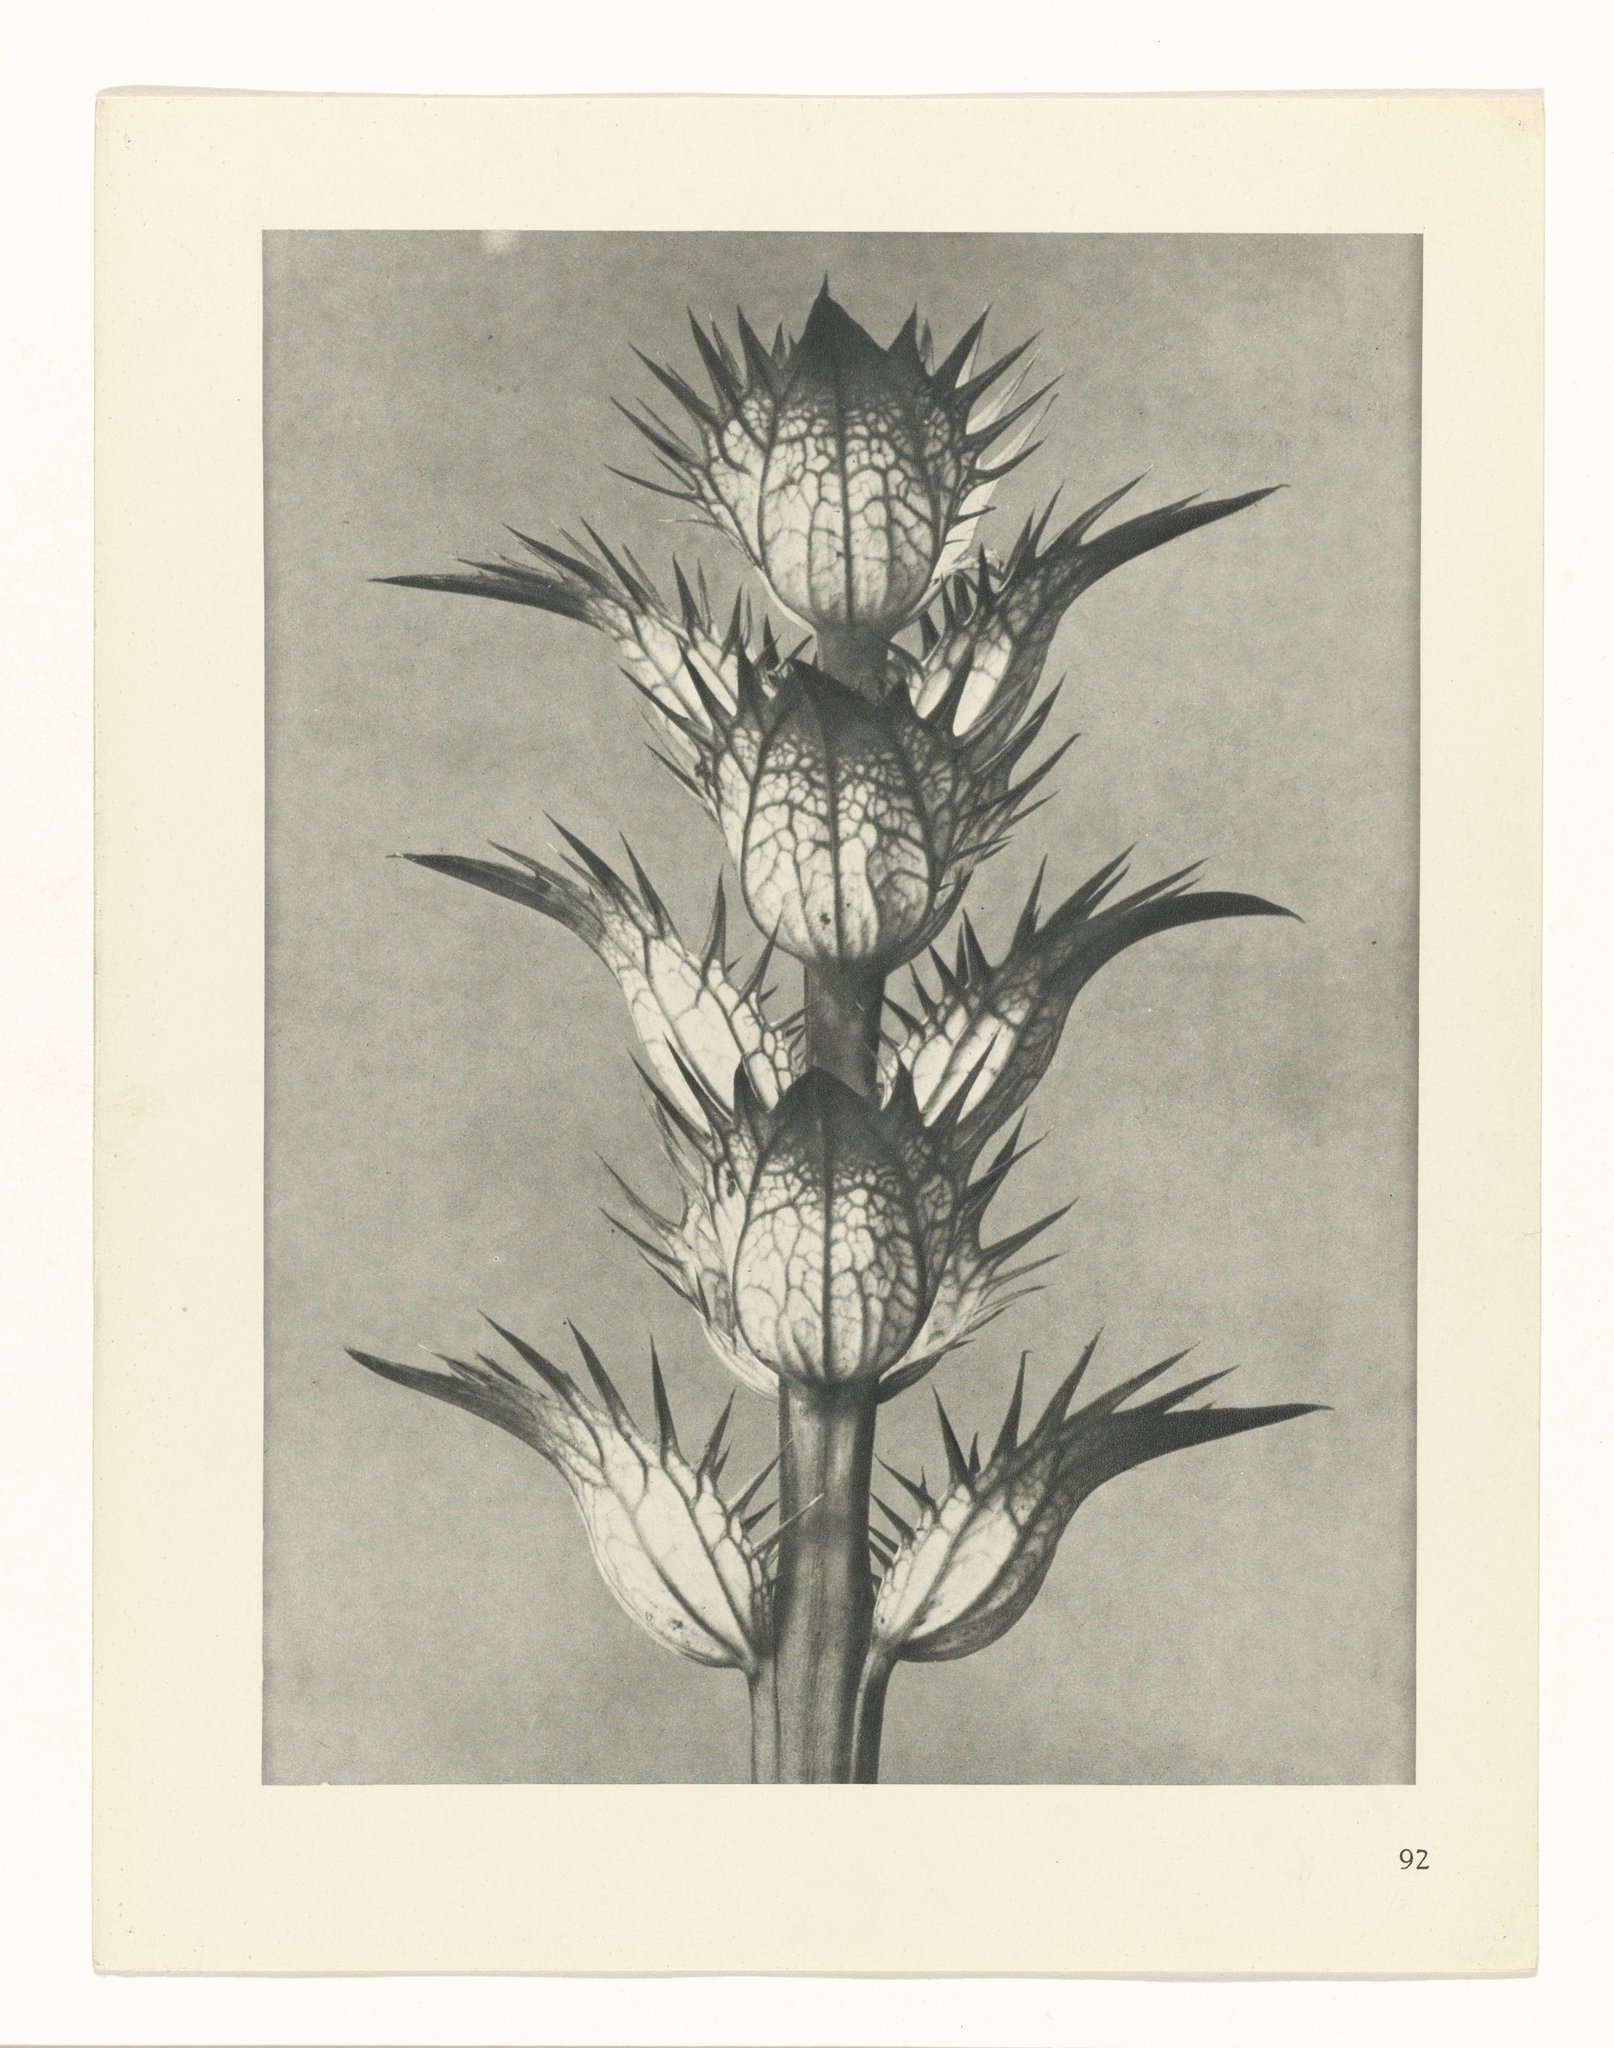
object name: photograph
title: Urformen der Kunst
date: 1928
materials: ink, paper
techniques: rotogravure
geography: berlin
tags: plants (in general)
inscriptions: number: ‘92’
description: facher Vergrößerung. Afkomstig uit losbladige uitgave.